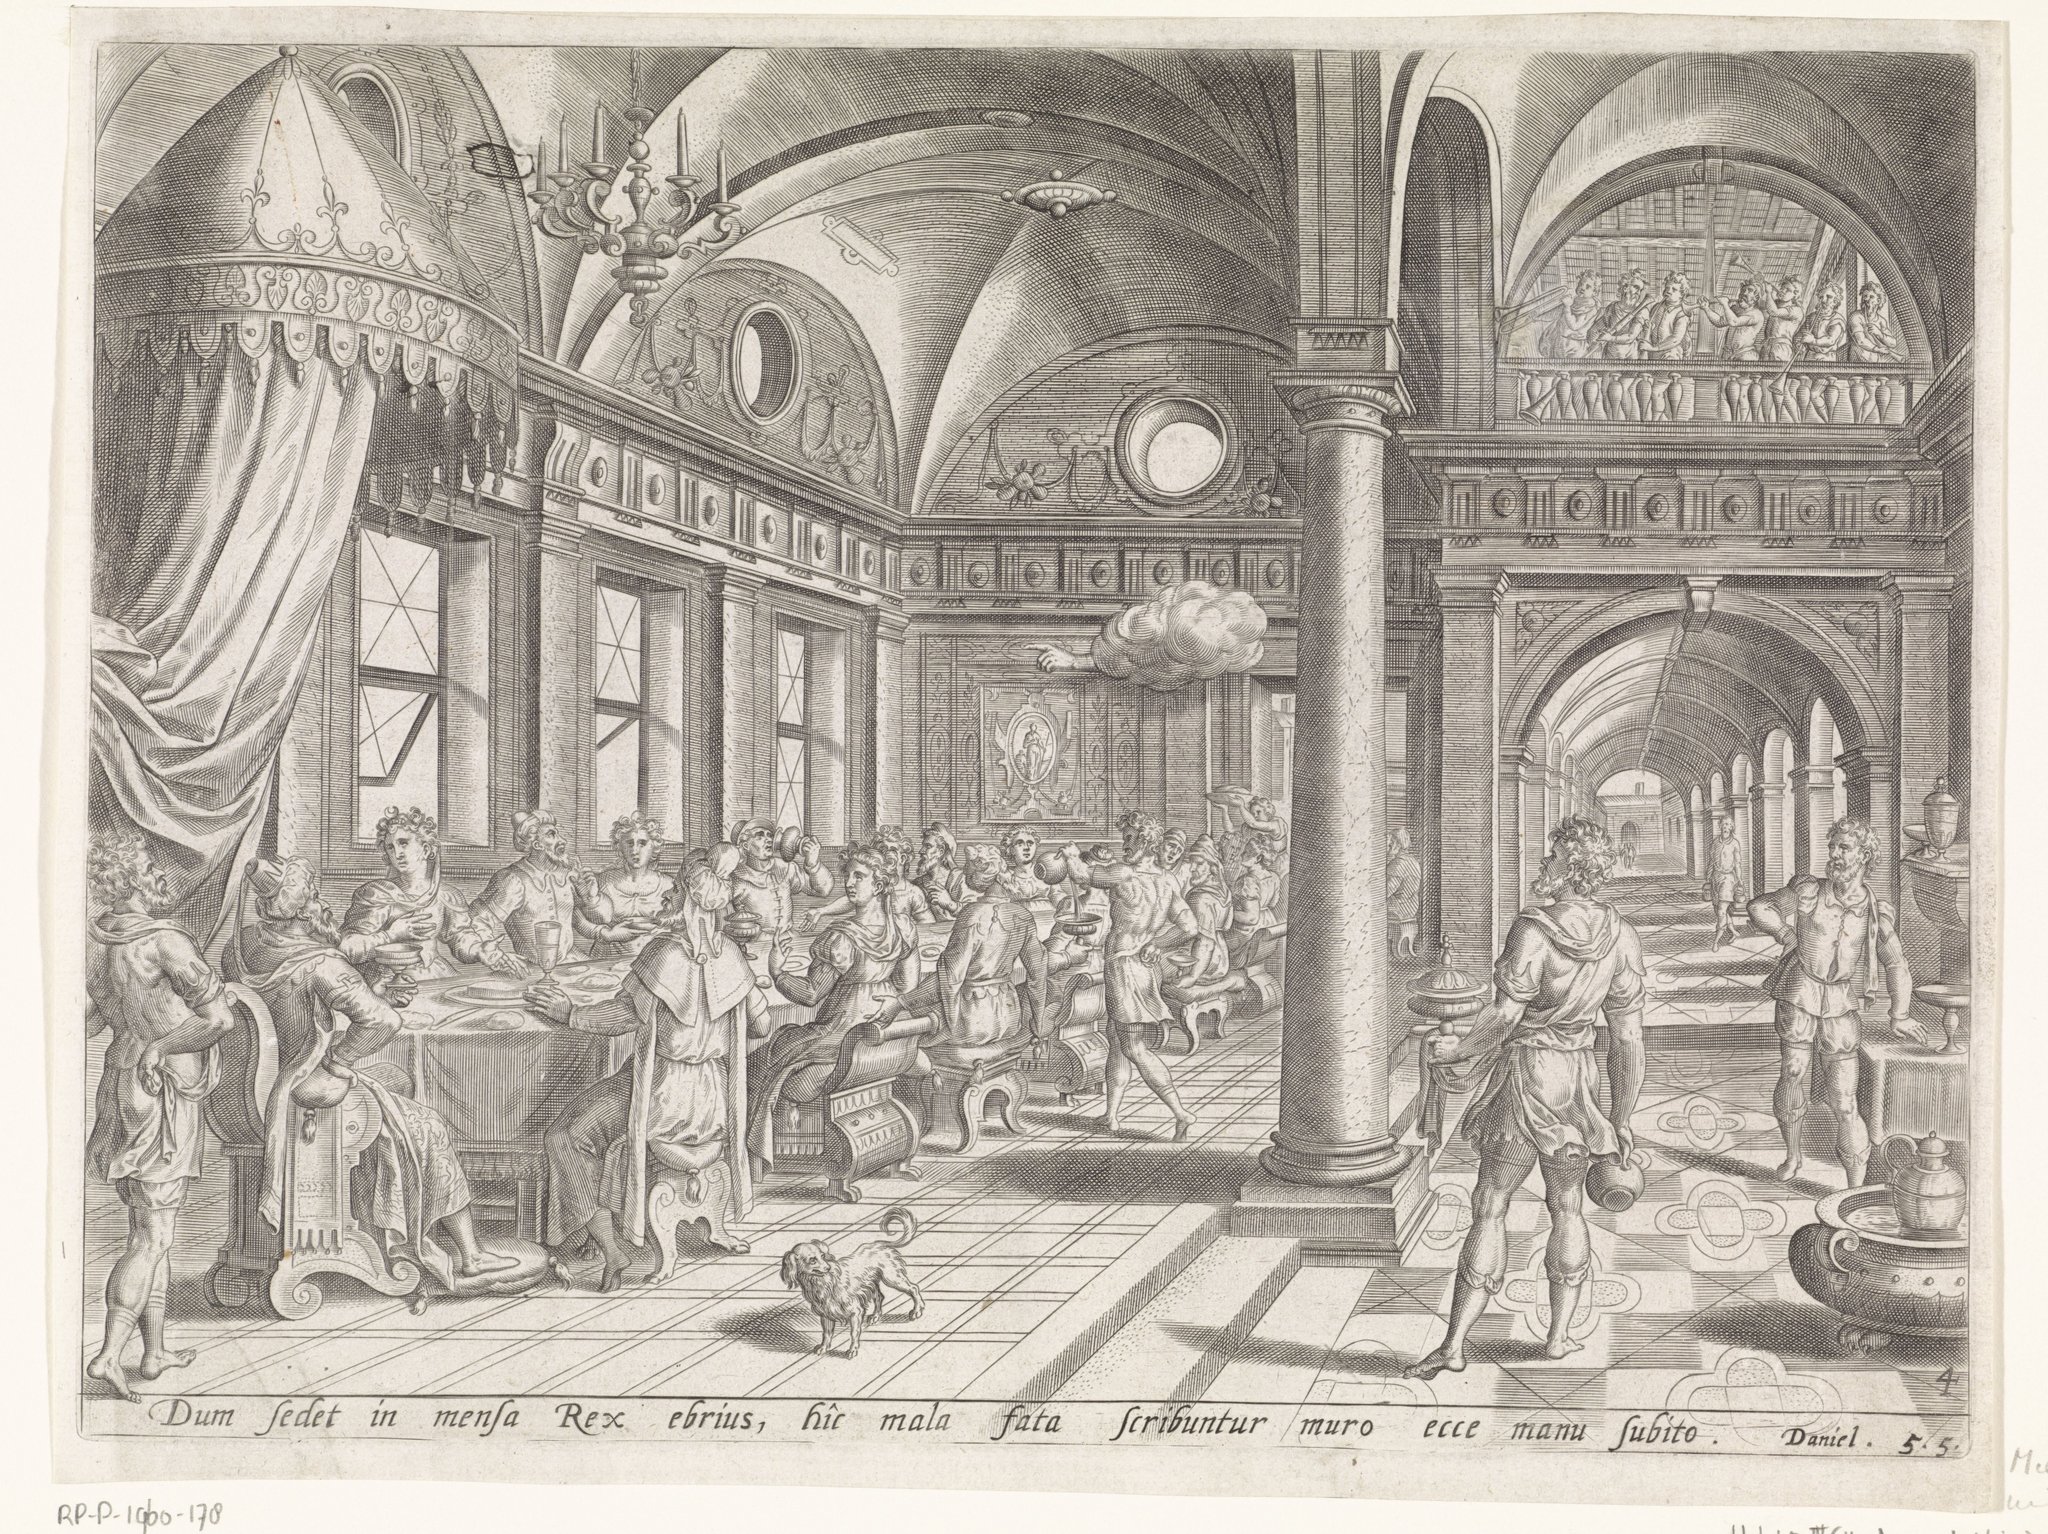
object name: print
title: Theatrum biblicum (...)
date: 1579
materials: paper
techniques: etching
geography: amsterdam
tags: during belshazzar's banquet a hand appears and writes on the wall (mene, mene, tekel and parsin (upharsin)); king belshazzar is frightened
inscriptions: collector's mark: Lugt 2228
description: Het feestmaal van Belsassar, koning van Babylon, met zijn hovelingen en vrouwen. Belsassar, op de rug gezien aan het hoofd van de tafel, ziet een schrijvende hand verschijnen. Op tafel staan de gestolen bekers en schalen uit de tempel van Jeruzalem. Rechtsboven staan trompetters op het balkon. Onder de voorstelling een verwijzing in het Latijn naar de Bijbeltekst in Dan. 5:5.